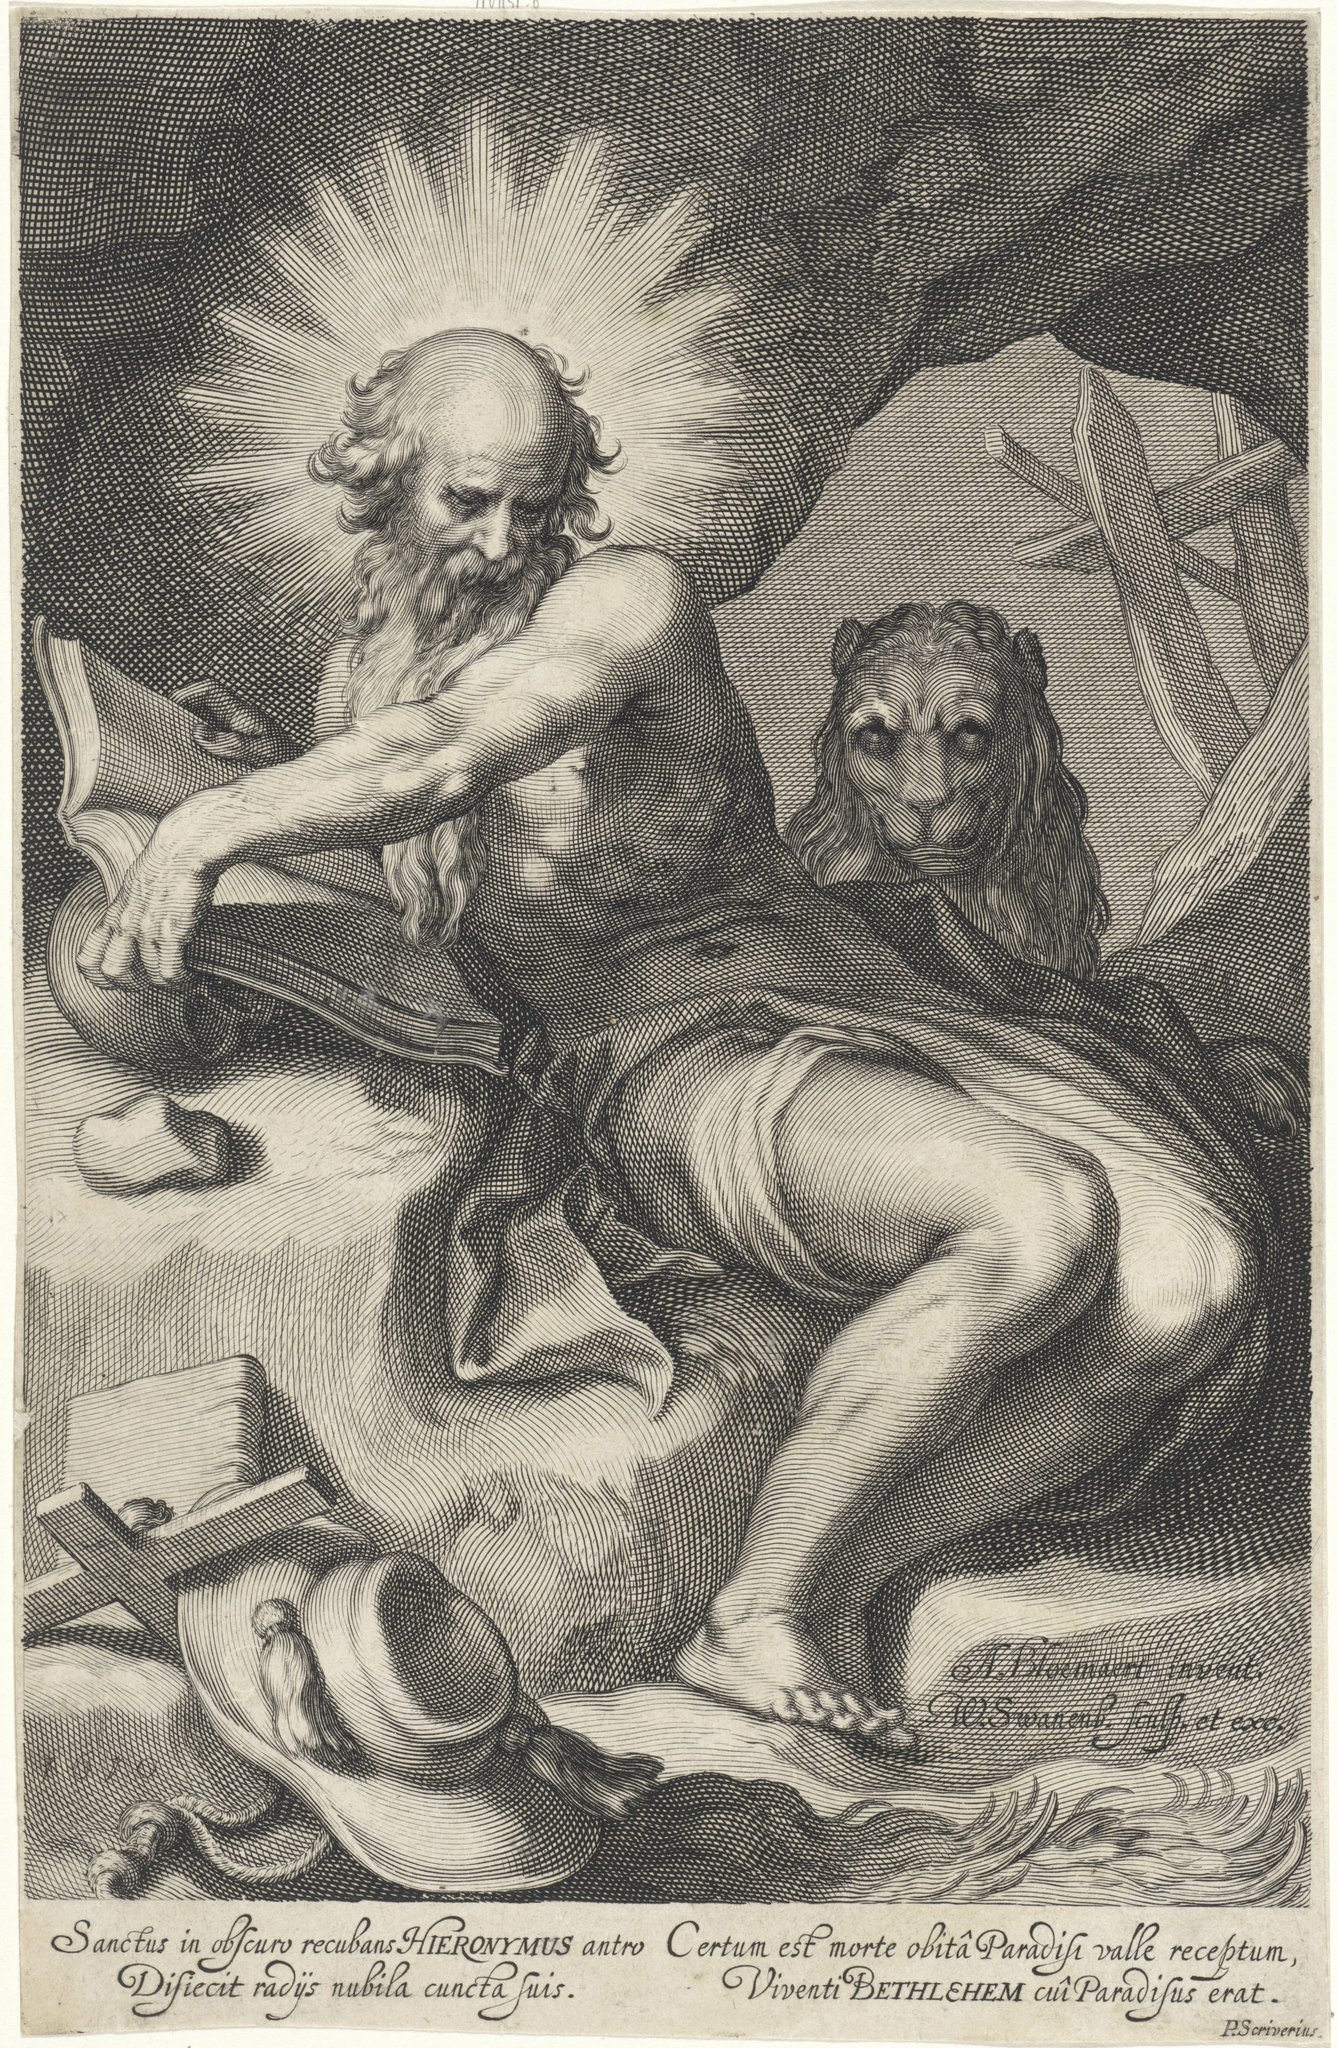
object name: print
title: H. Hieronymus in een grot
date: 1610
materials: paper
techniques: engraving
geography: leiden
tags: the monk and hermit jerome (hieronymus); possible attributes: book, cardinal's hat, crucifix, hour-glass, lion, skull, stone - portrait of male saint, cave, grotto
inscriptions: collector's mark: Lugt 240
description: Hieronymus zit in een grot. Rond zijn hoofd is een stralenkrans te zien. Hij houdt een boek vast. Onder het boek ligt een schedel naast een steen. Bij zijn voeten is een boek, een kardinaalshoed en een kruis te zien. Achter hem ligt een leeuw. Onder de voorstelling bevindt zich een vierregelige, Latijnse tekst met een beschrijving van de scène.